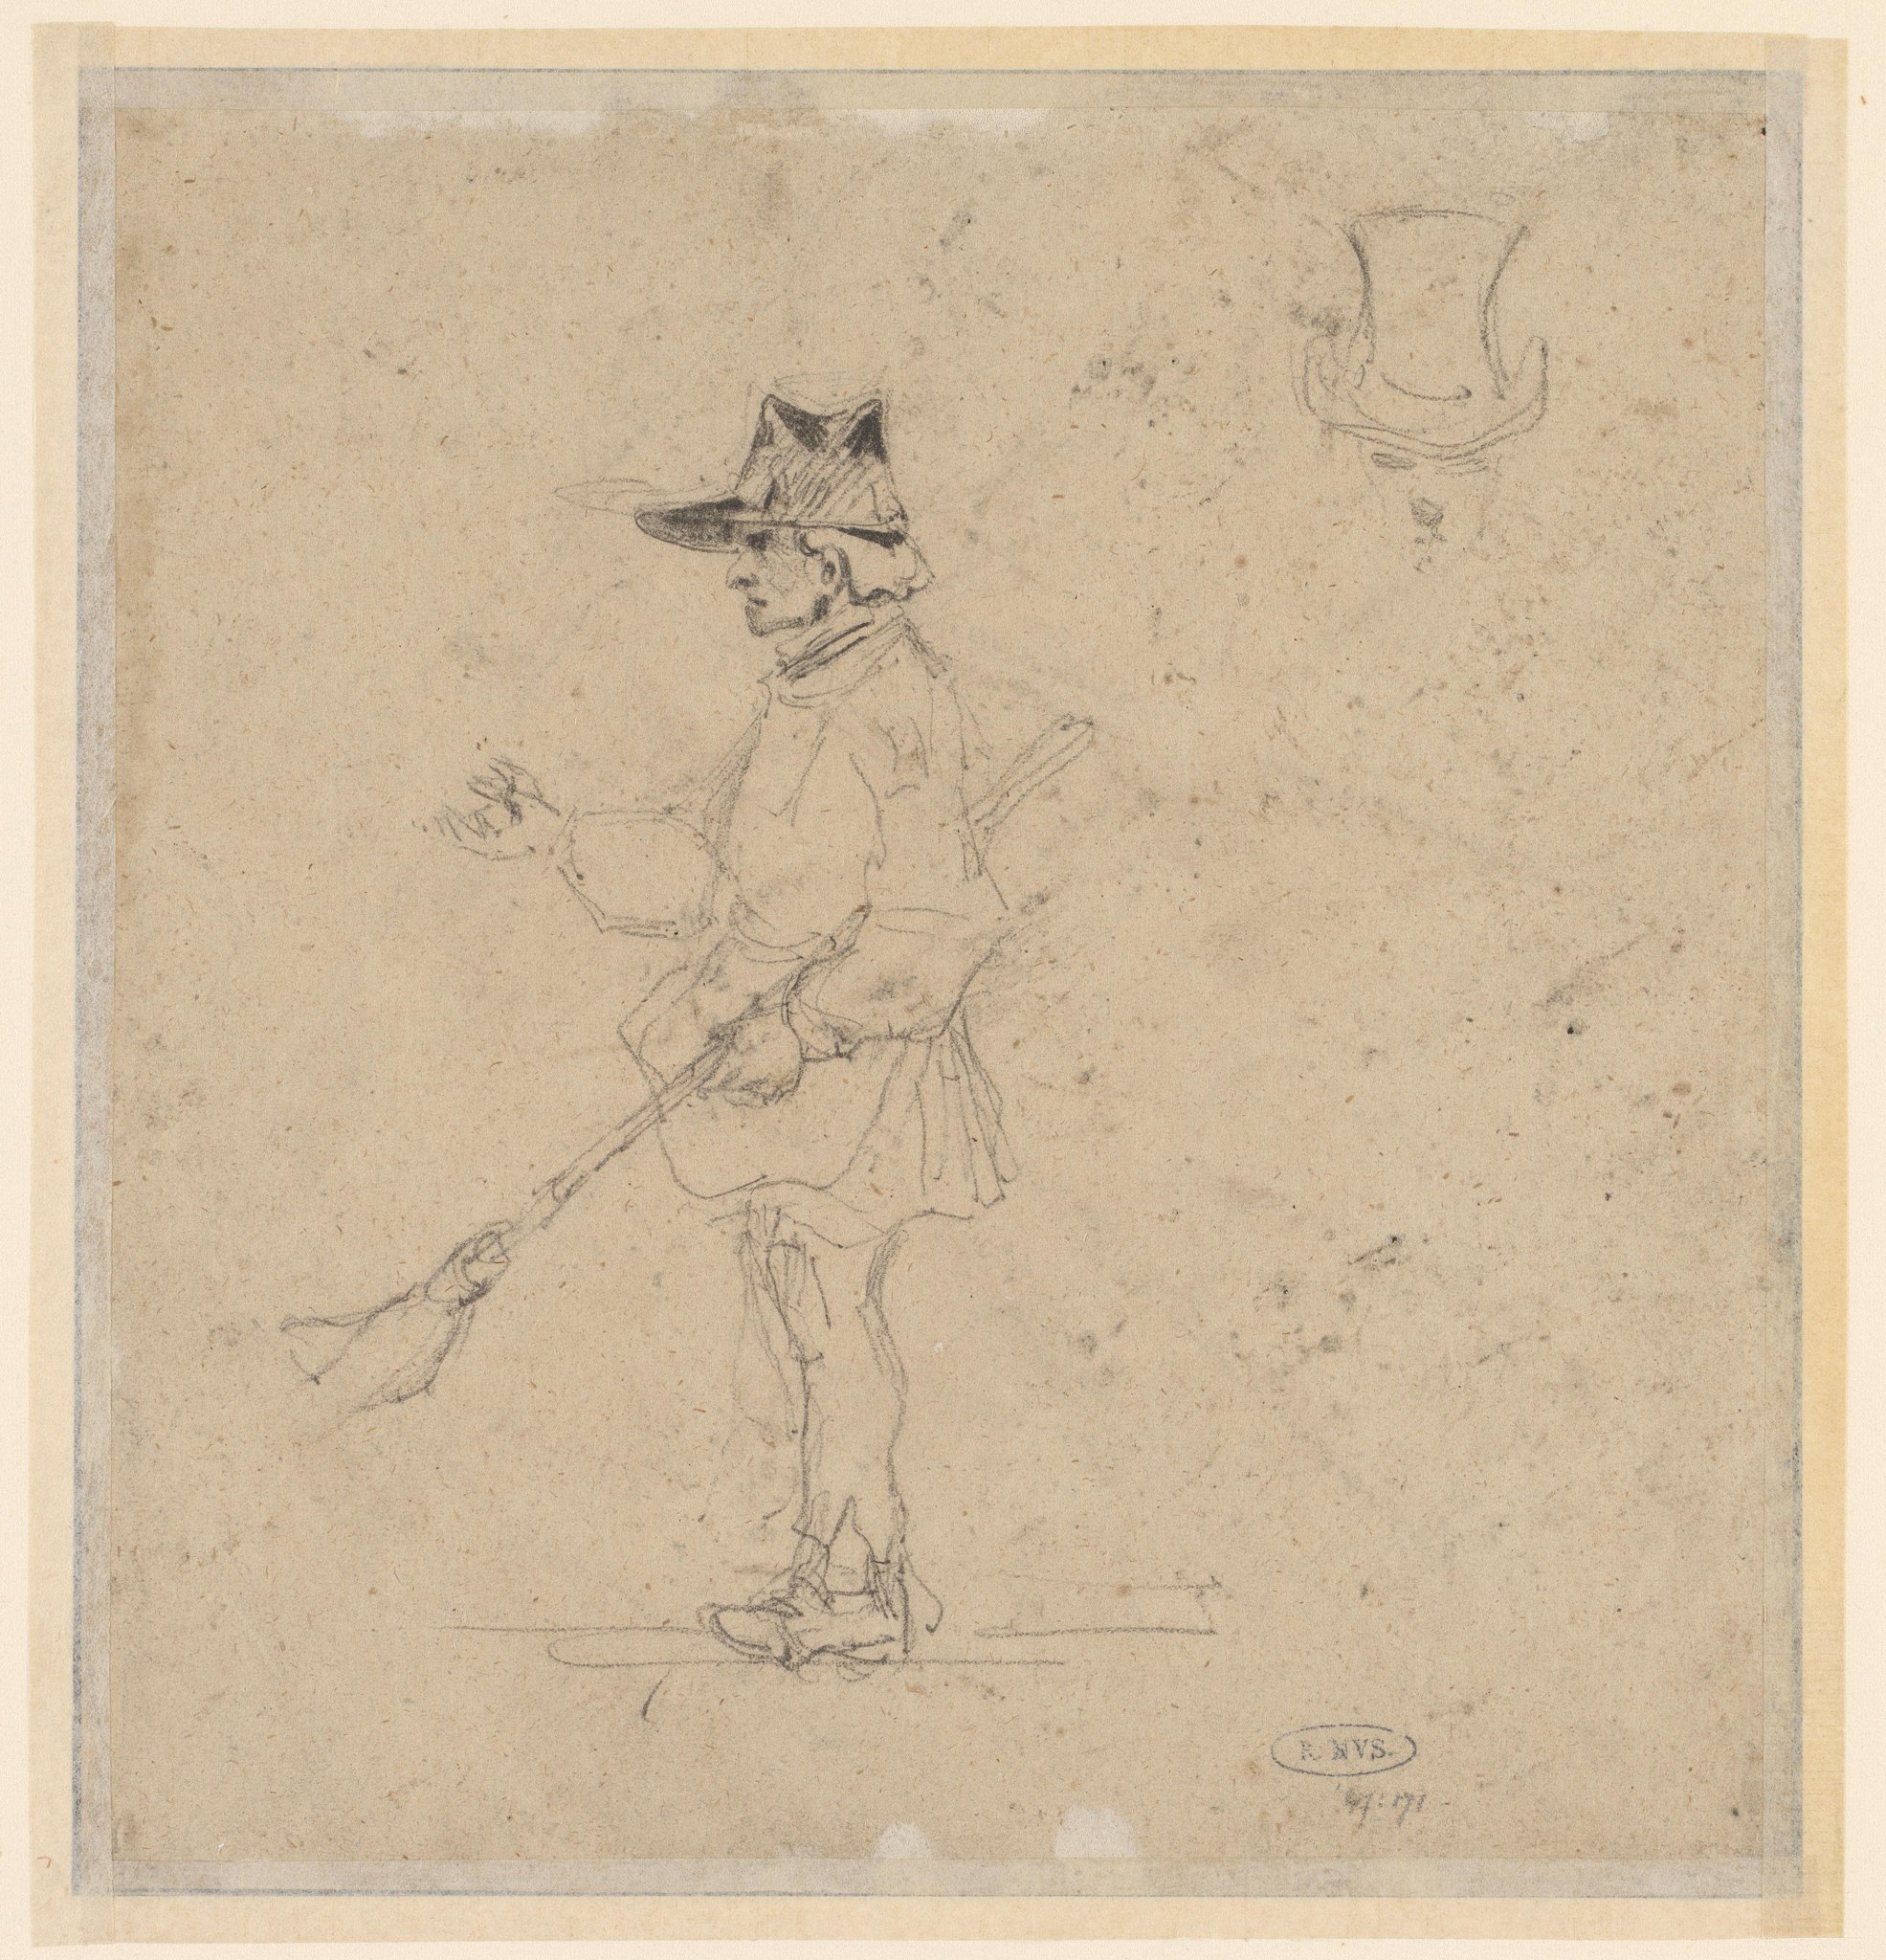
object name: drawing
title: Schets van een straatveger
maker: frantz charlet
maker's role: draughtsman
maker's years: 1862-1928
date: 1872-1928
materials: chalk, paper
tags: working class, labourers, garbage collection